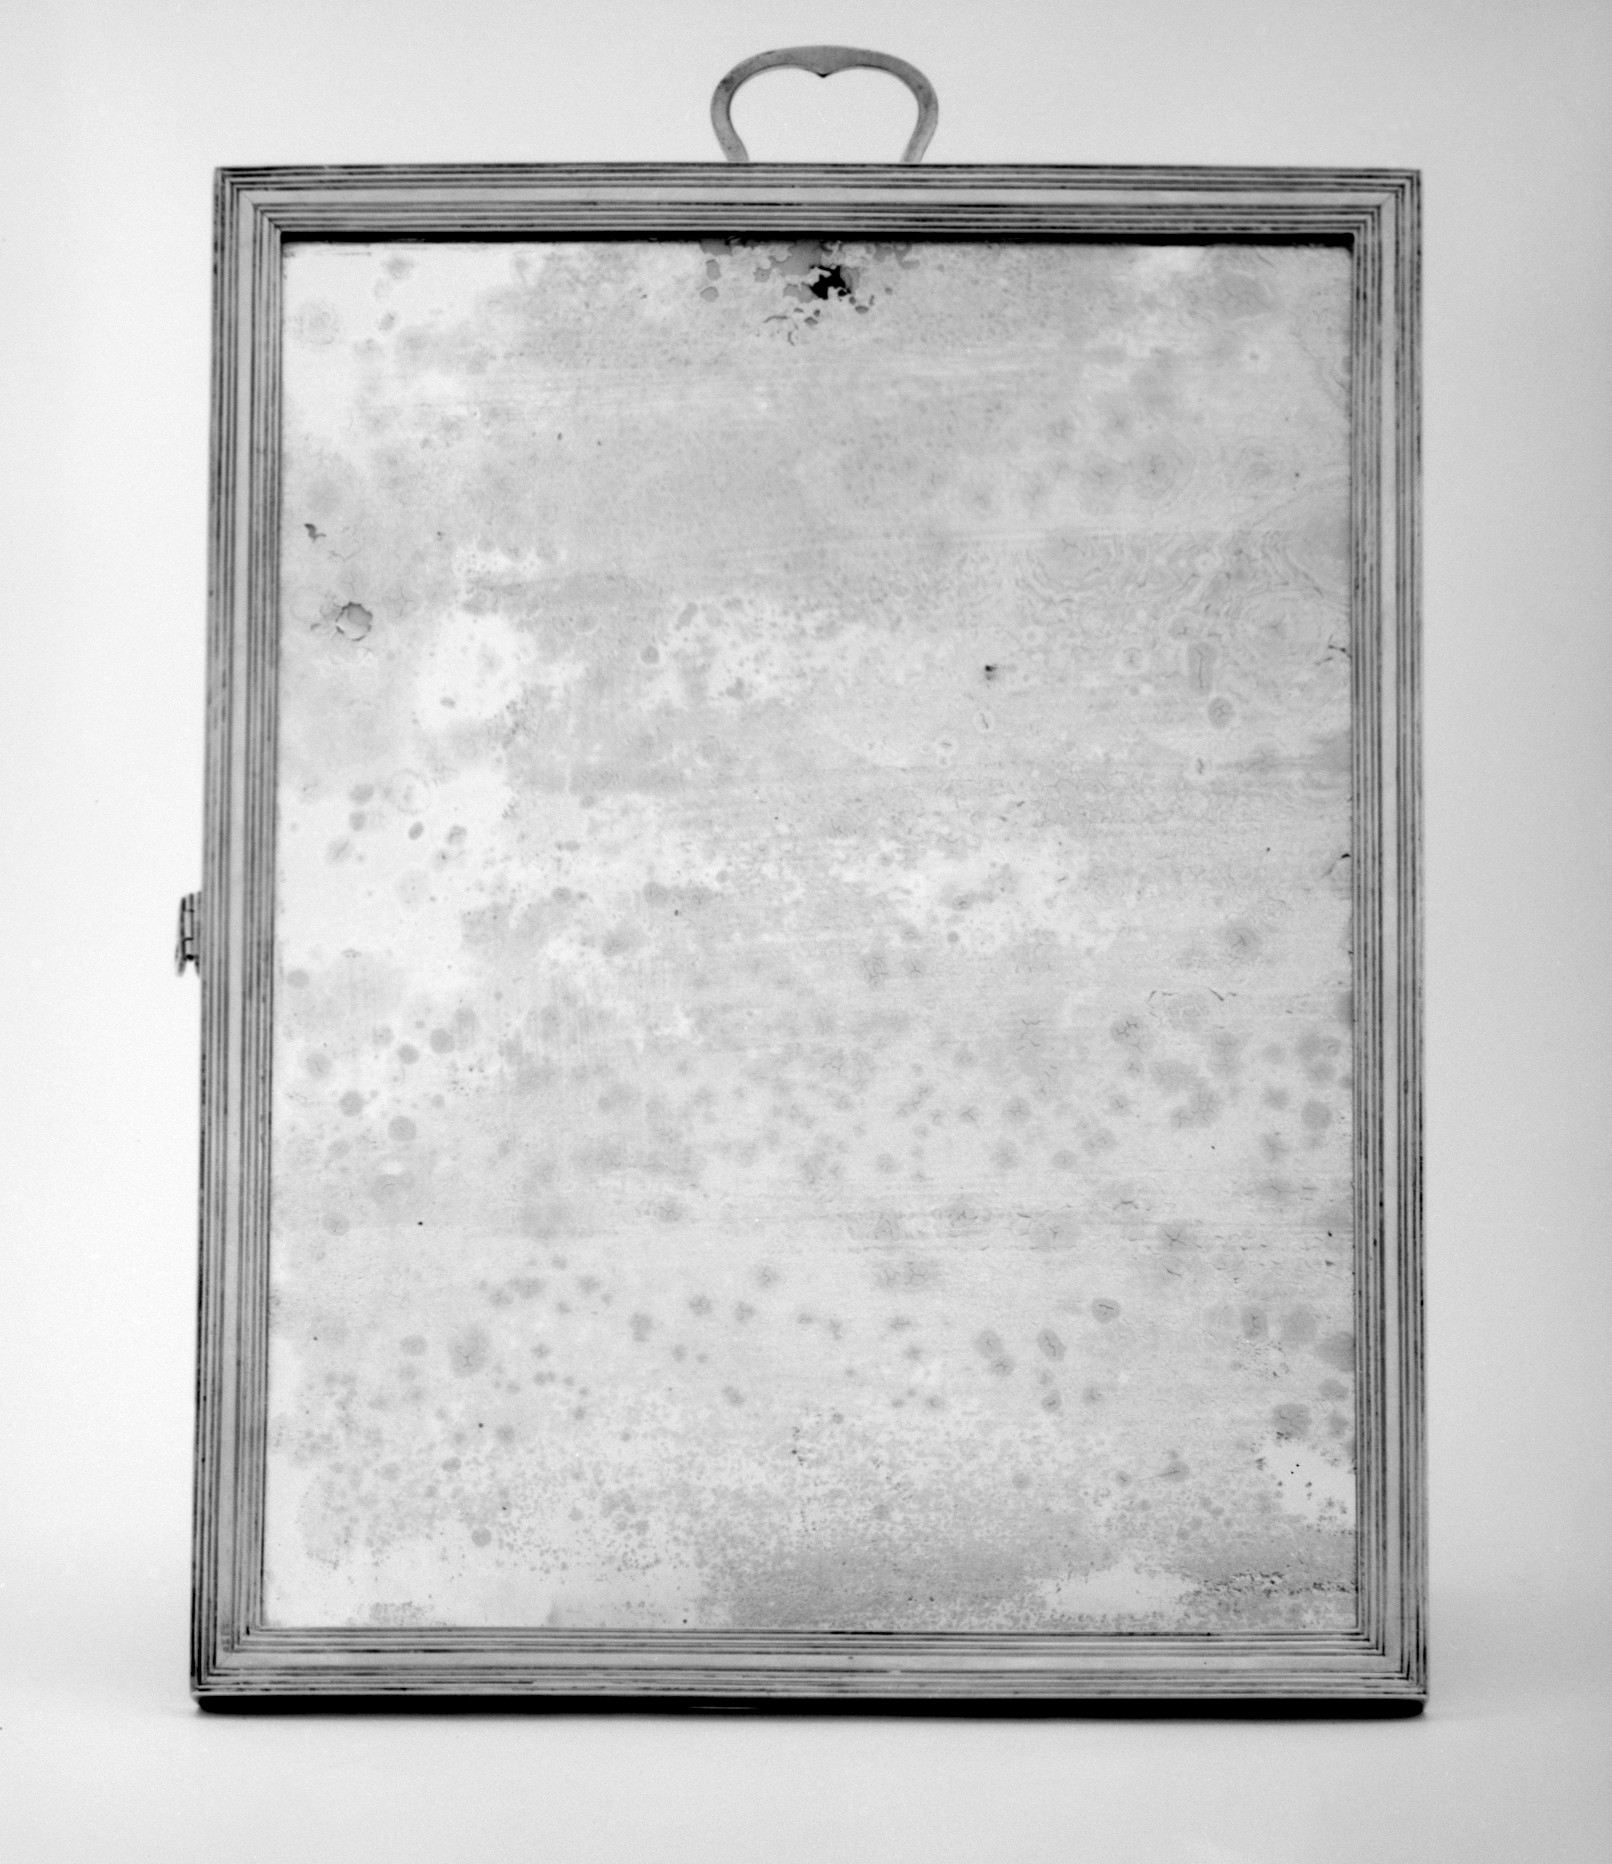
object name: mirror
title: Three mirrors (part of a set)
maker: johan fredrik falck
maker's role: maker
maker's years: 1838-1845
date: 1848-1849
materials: glass, silver, wood